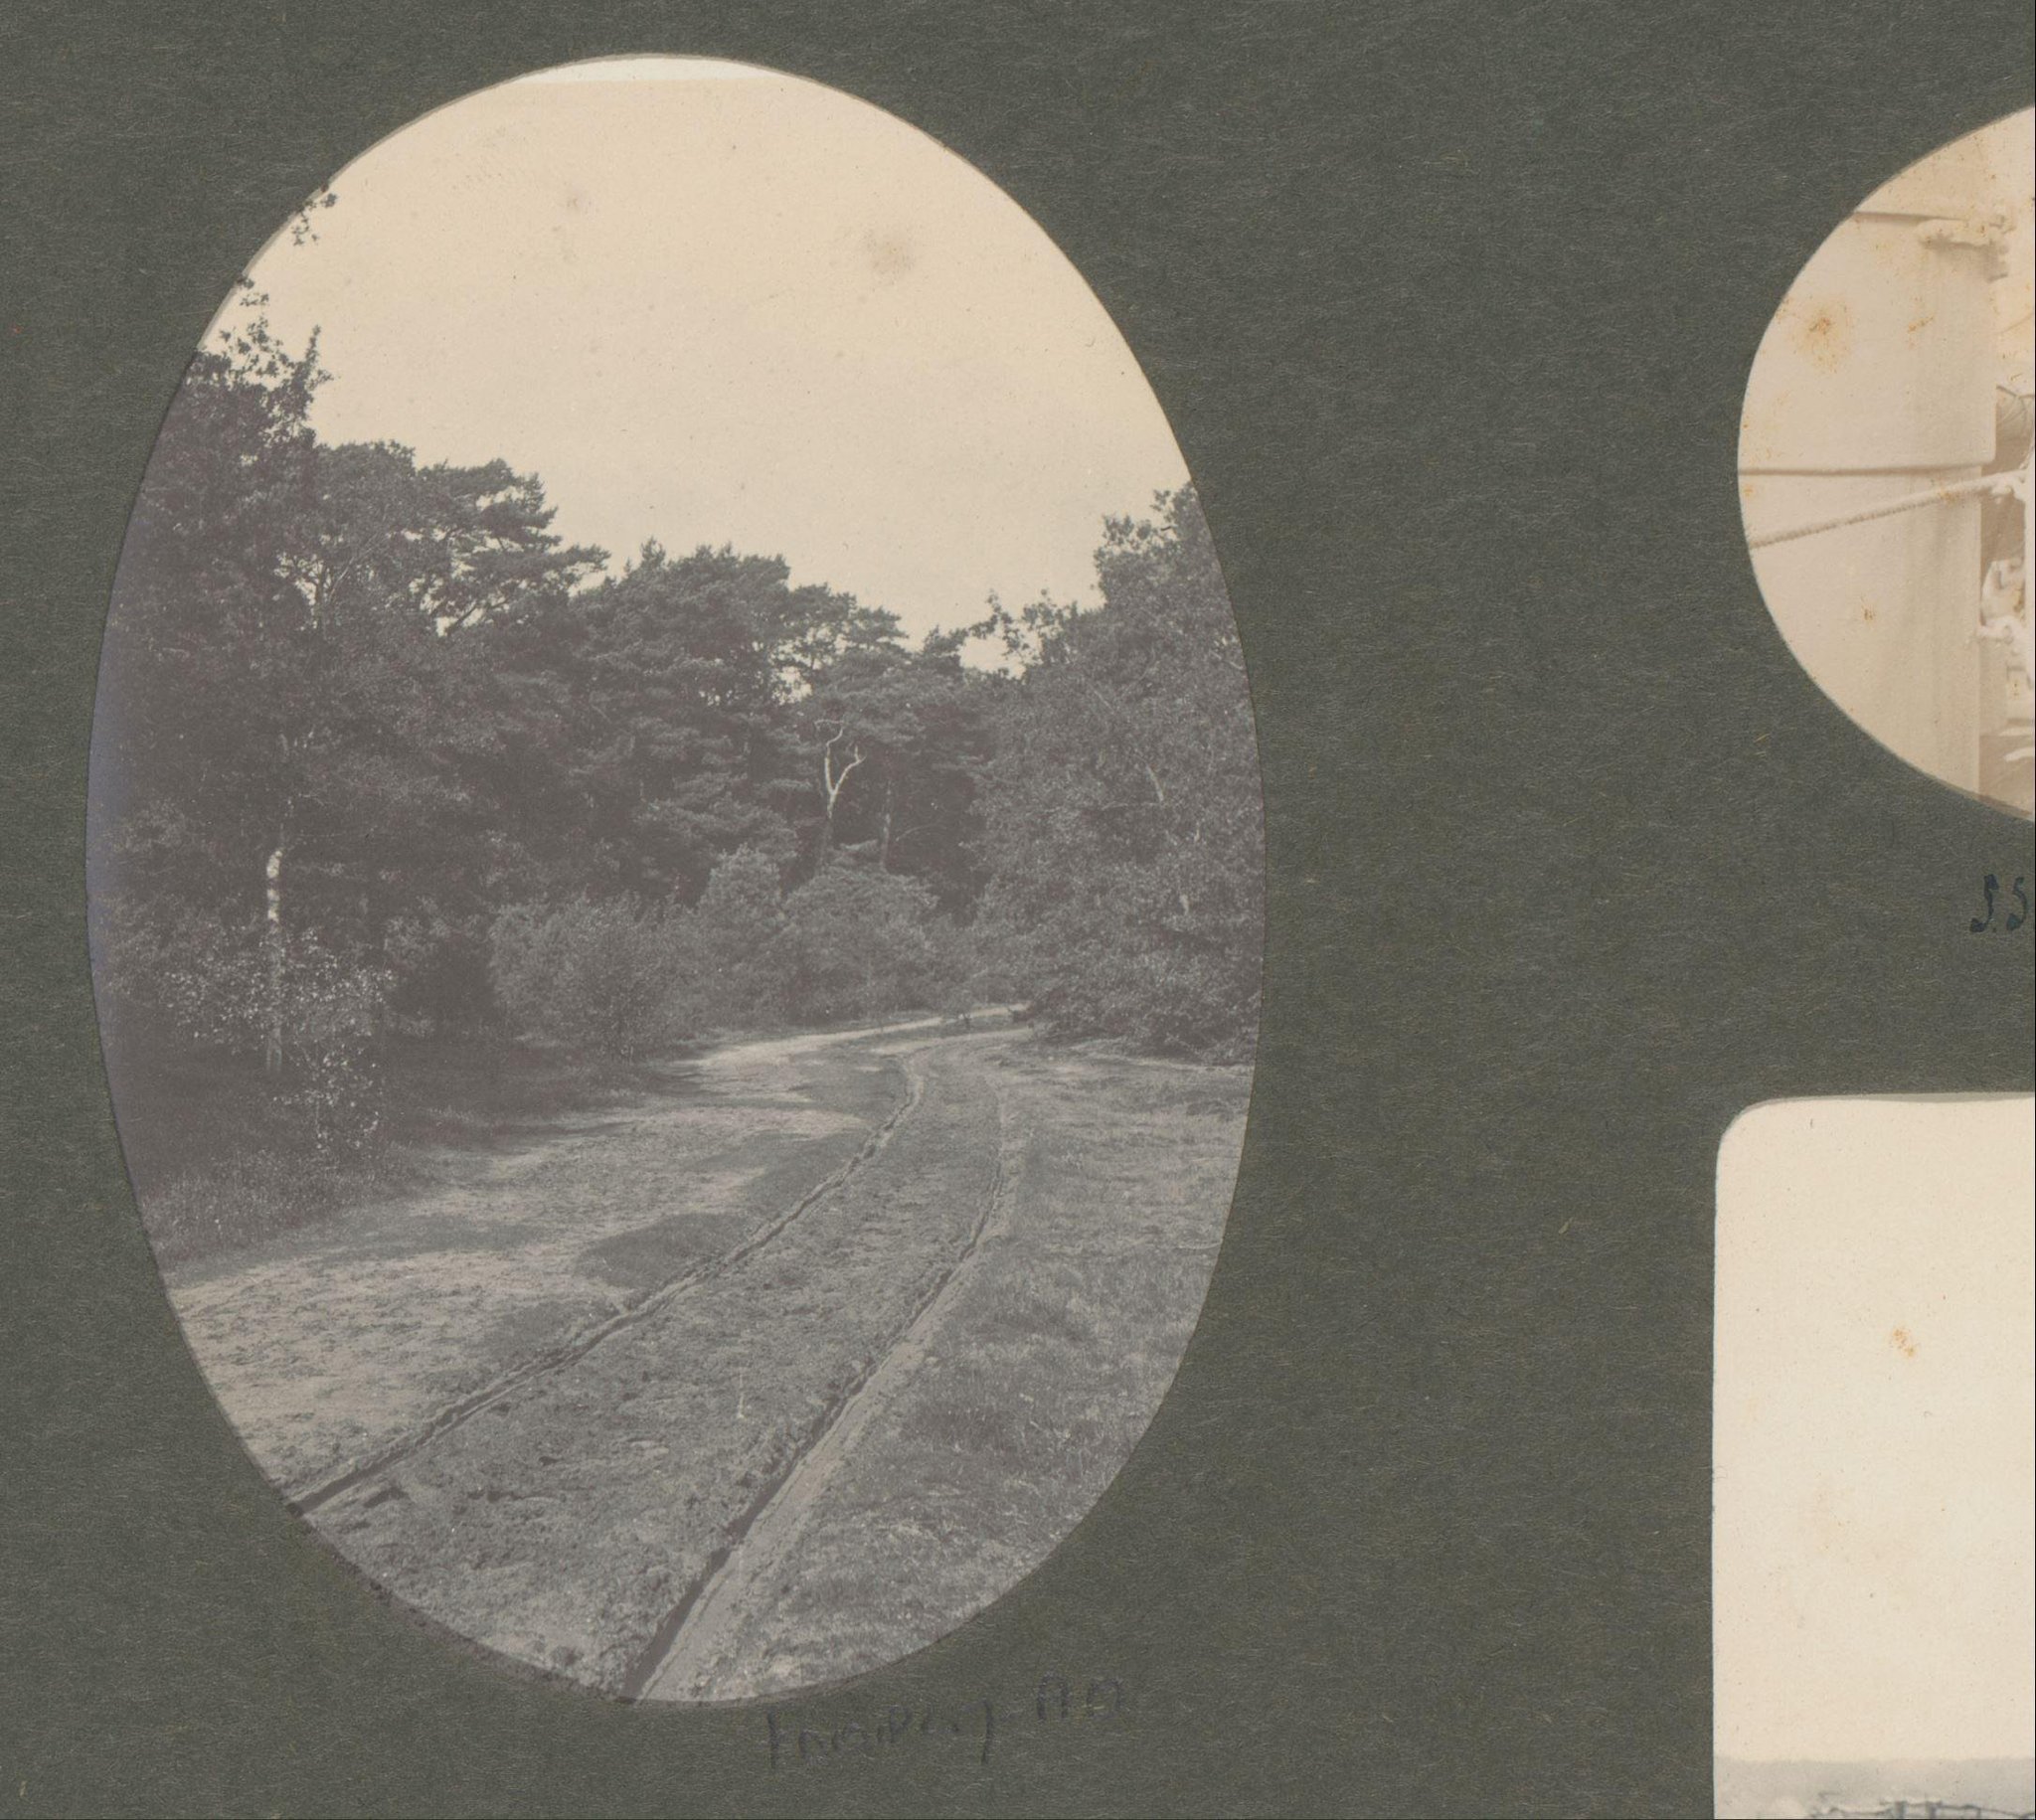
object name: album leaf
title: Bosweg met karrenspoor, vermoedelijk in Nederland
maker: Anonymous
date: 1902-1906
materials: cardboard, paper, photographic support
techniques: gelatin silver print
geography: netherlands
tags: road, path, netherlands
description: Onderdeel van Reisalbum van een Nederlandse familie met bezienswaardigheden in Europa, Egypte en New York.